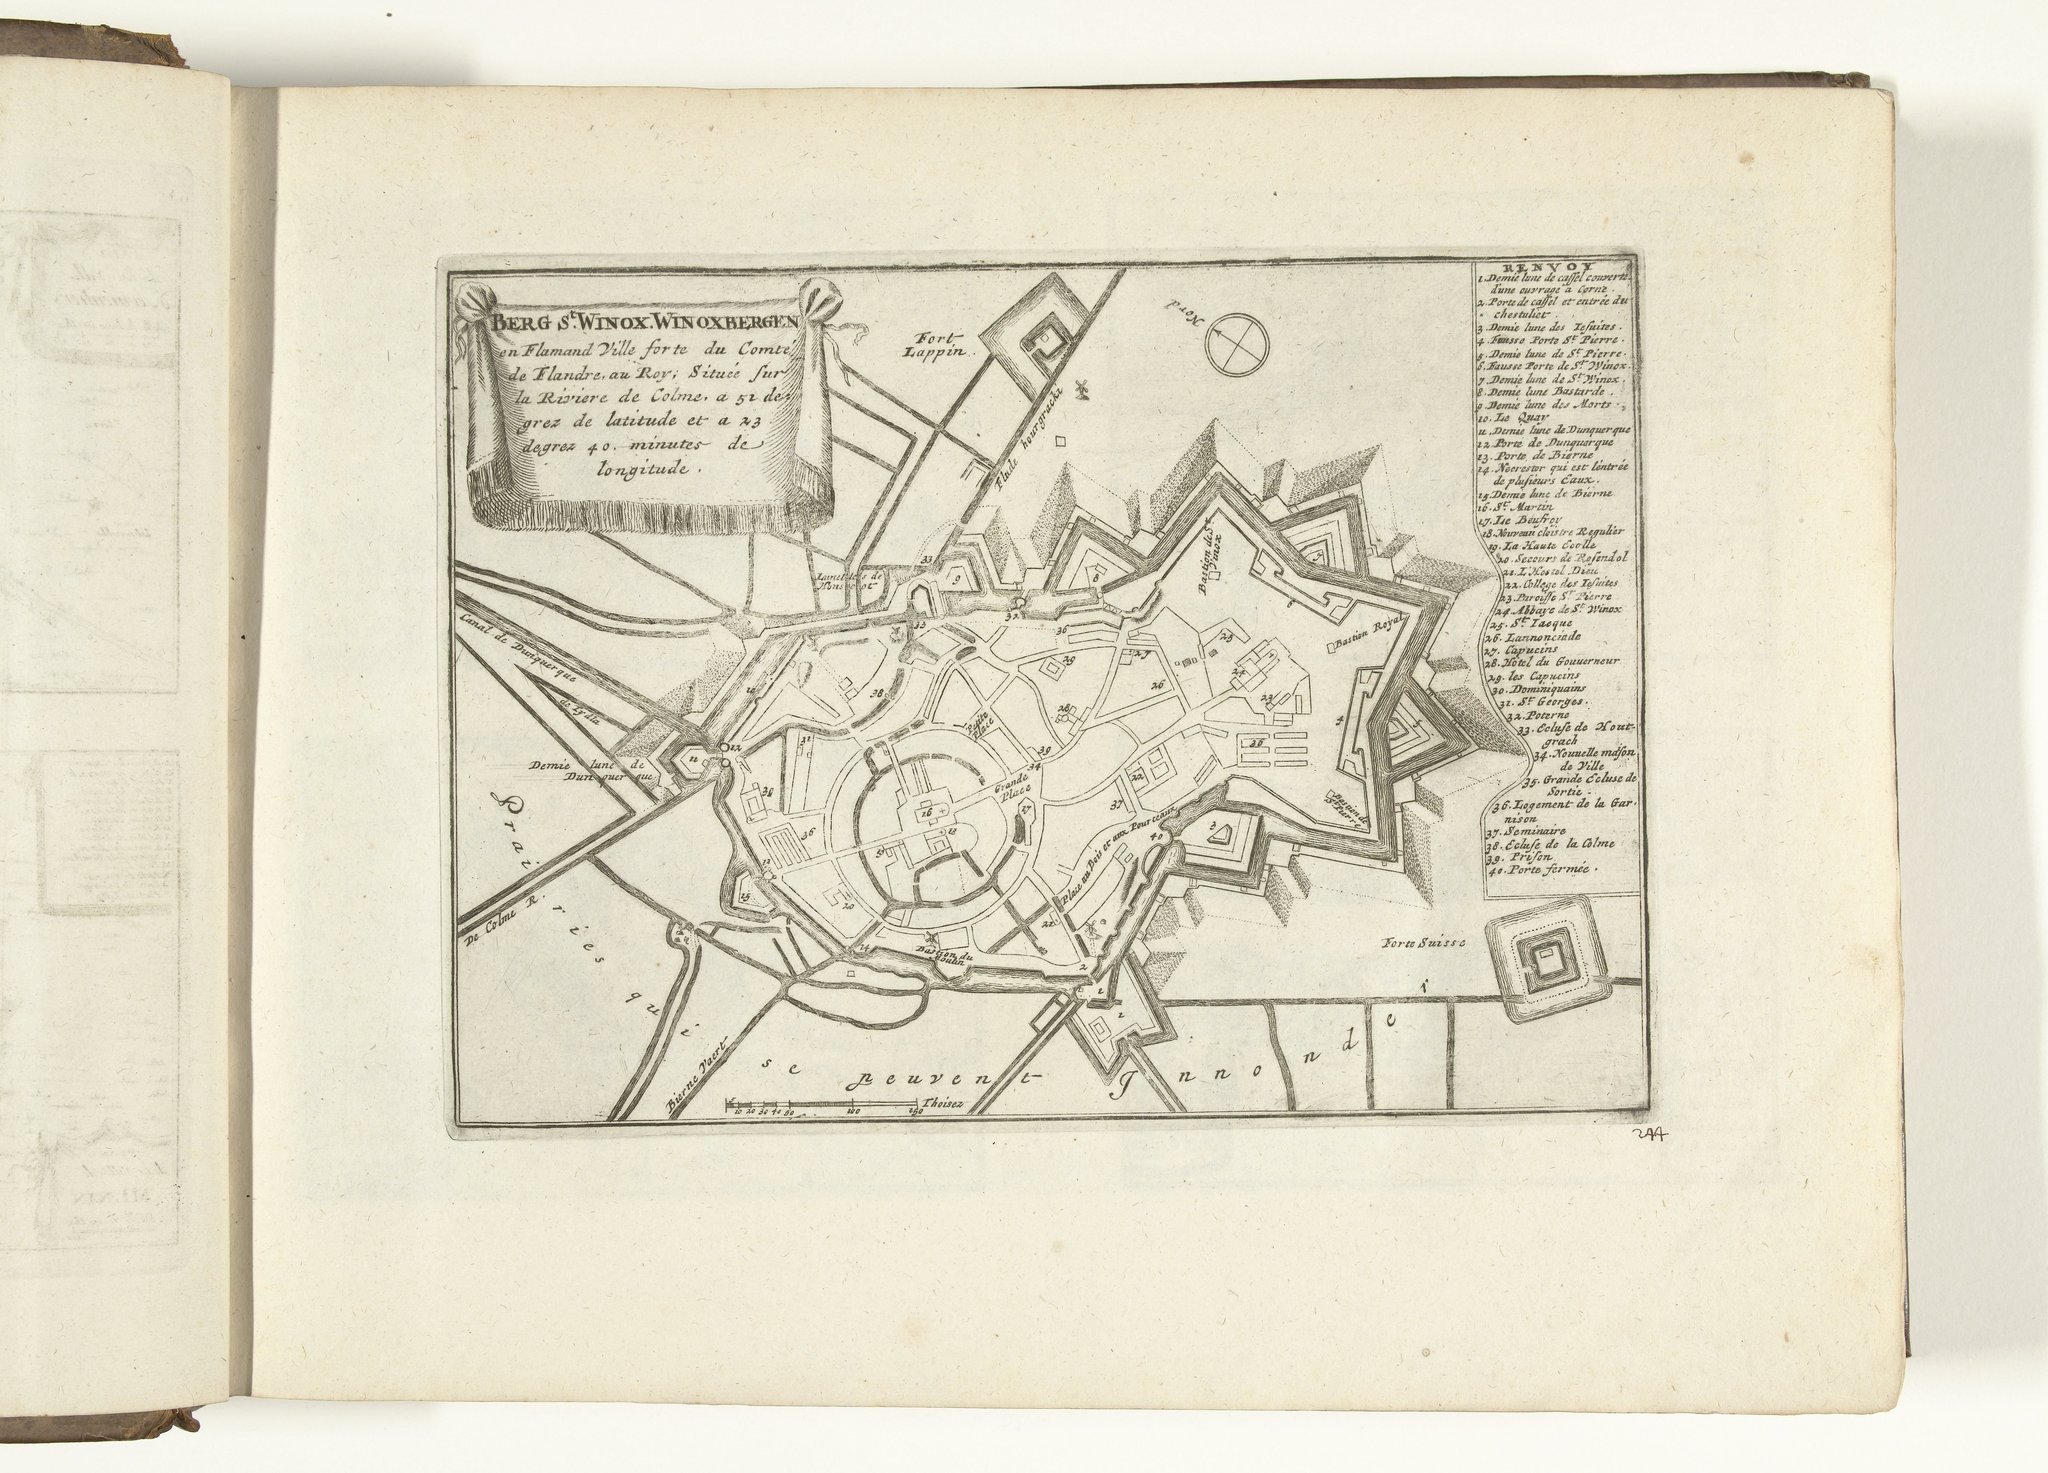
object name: print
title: Plattegrond van Sint-Winoksbergen, 1726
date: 1726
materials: paper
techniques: etching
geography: northern netherlands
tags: fortress, maps of cities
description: Plattegrond van de versterkingen om de Vlaamse (nu Franse) stad Sint-Winoksbergen (Bergues). Plaat nr. 244 in deel XI van het prentwerk: Les Forces de l'Europe, Asie, Afrique et Amerique ... Comme aussi les Cartes des Côtes de France et d'Espagne uit 1726, dit tweede deel met 271 met de hand genummerde platen van vermaarde sterke steden en vestingen in het kader van de Spaanse Successieoorlog 1701-1713. Voor het merendeel zijn deze platen gekopieerd naar de anonieme Franse platen van vermaarde sterke steden en vestingen: in Les forces de l'Europe en in: Le theatre de la guerre, dans les Pays-Bas, beide oorspronkelijk uitgegeven door Nicolas de Fer te Parijs (1693-1697) in het kader van de Negenjarige Oorlog. Titel en opschriften in het Frans.